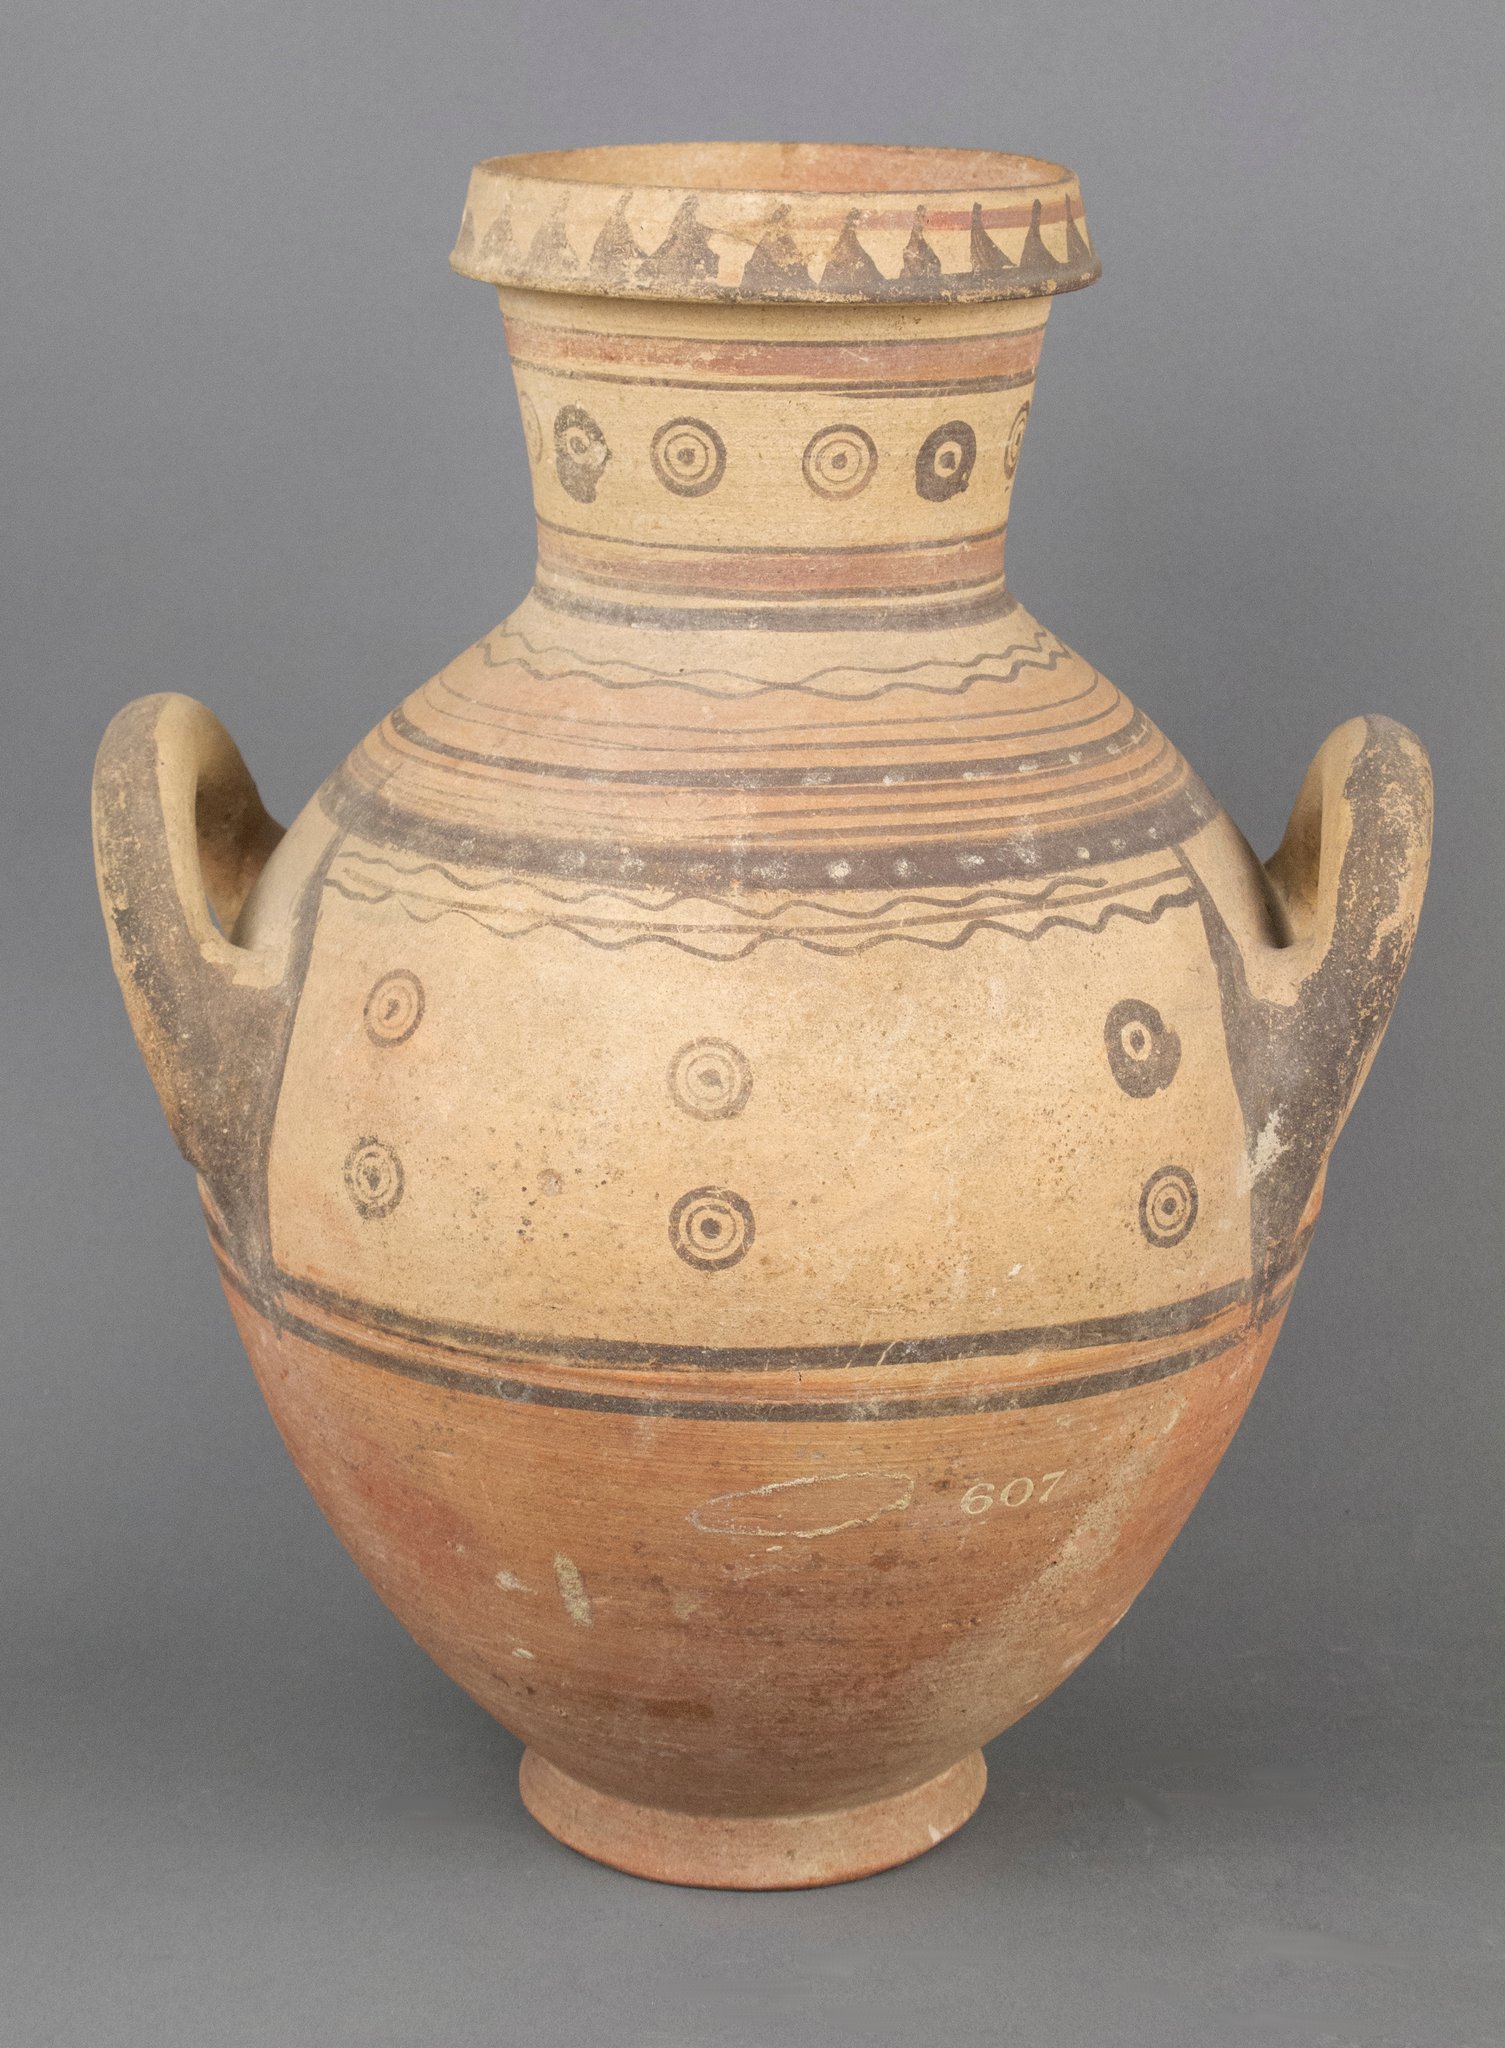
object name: amphora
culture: cypriot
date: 650-480 BCE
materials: terracotta